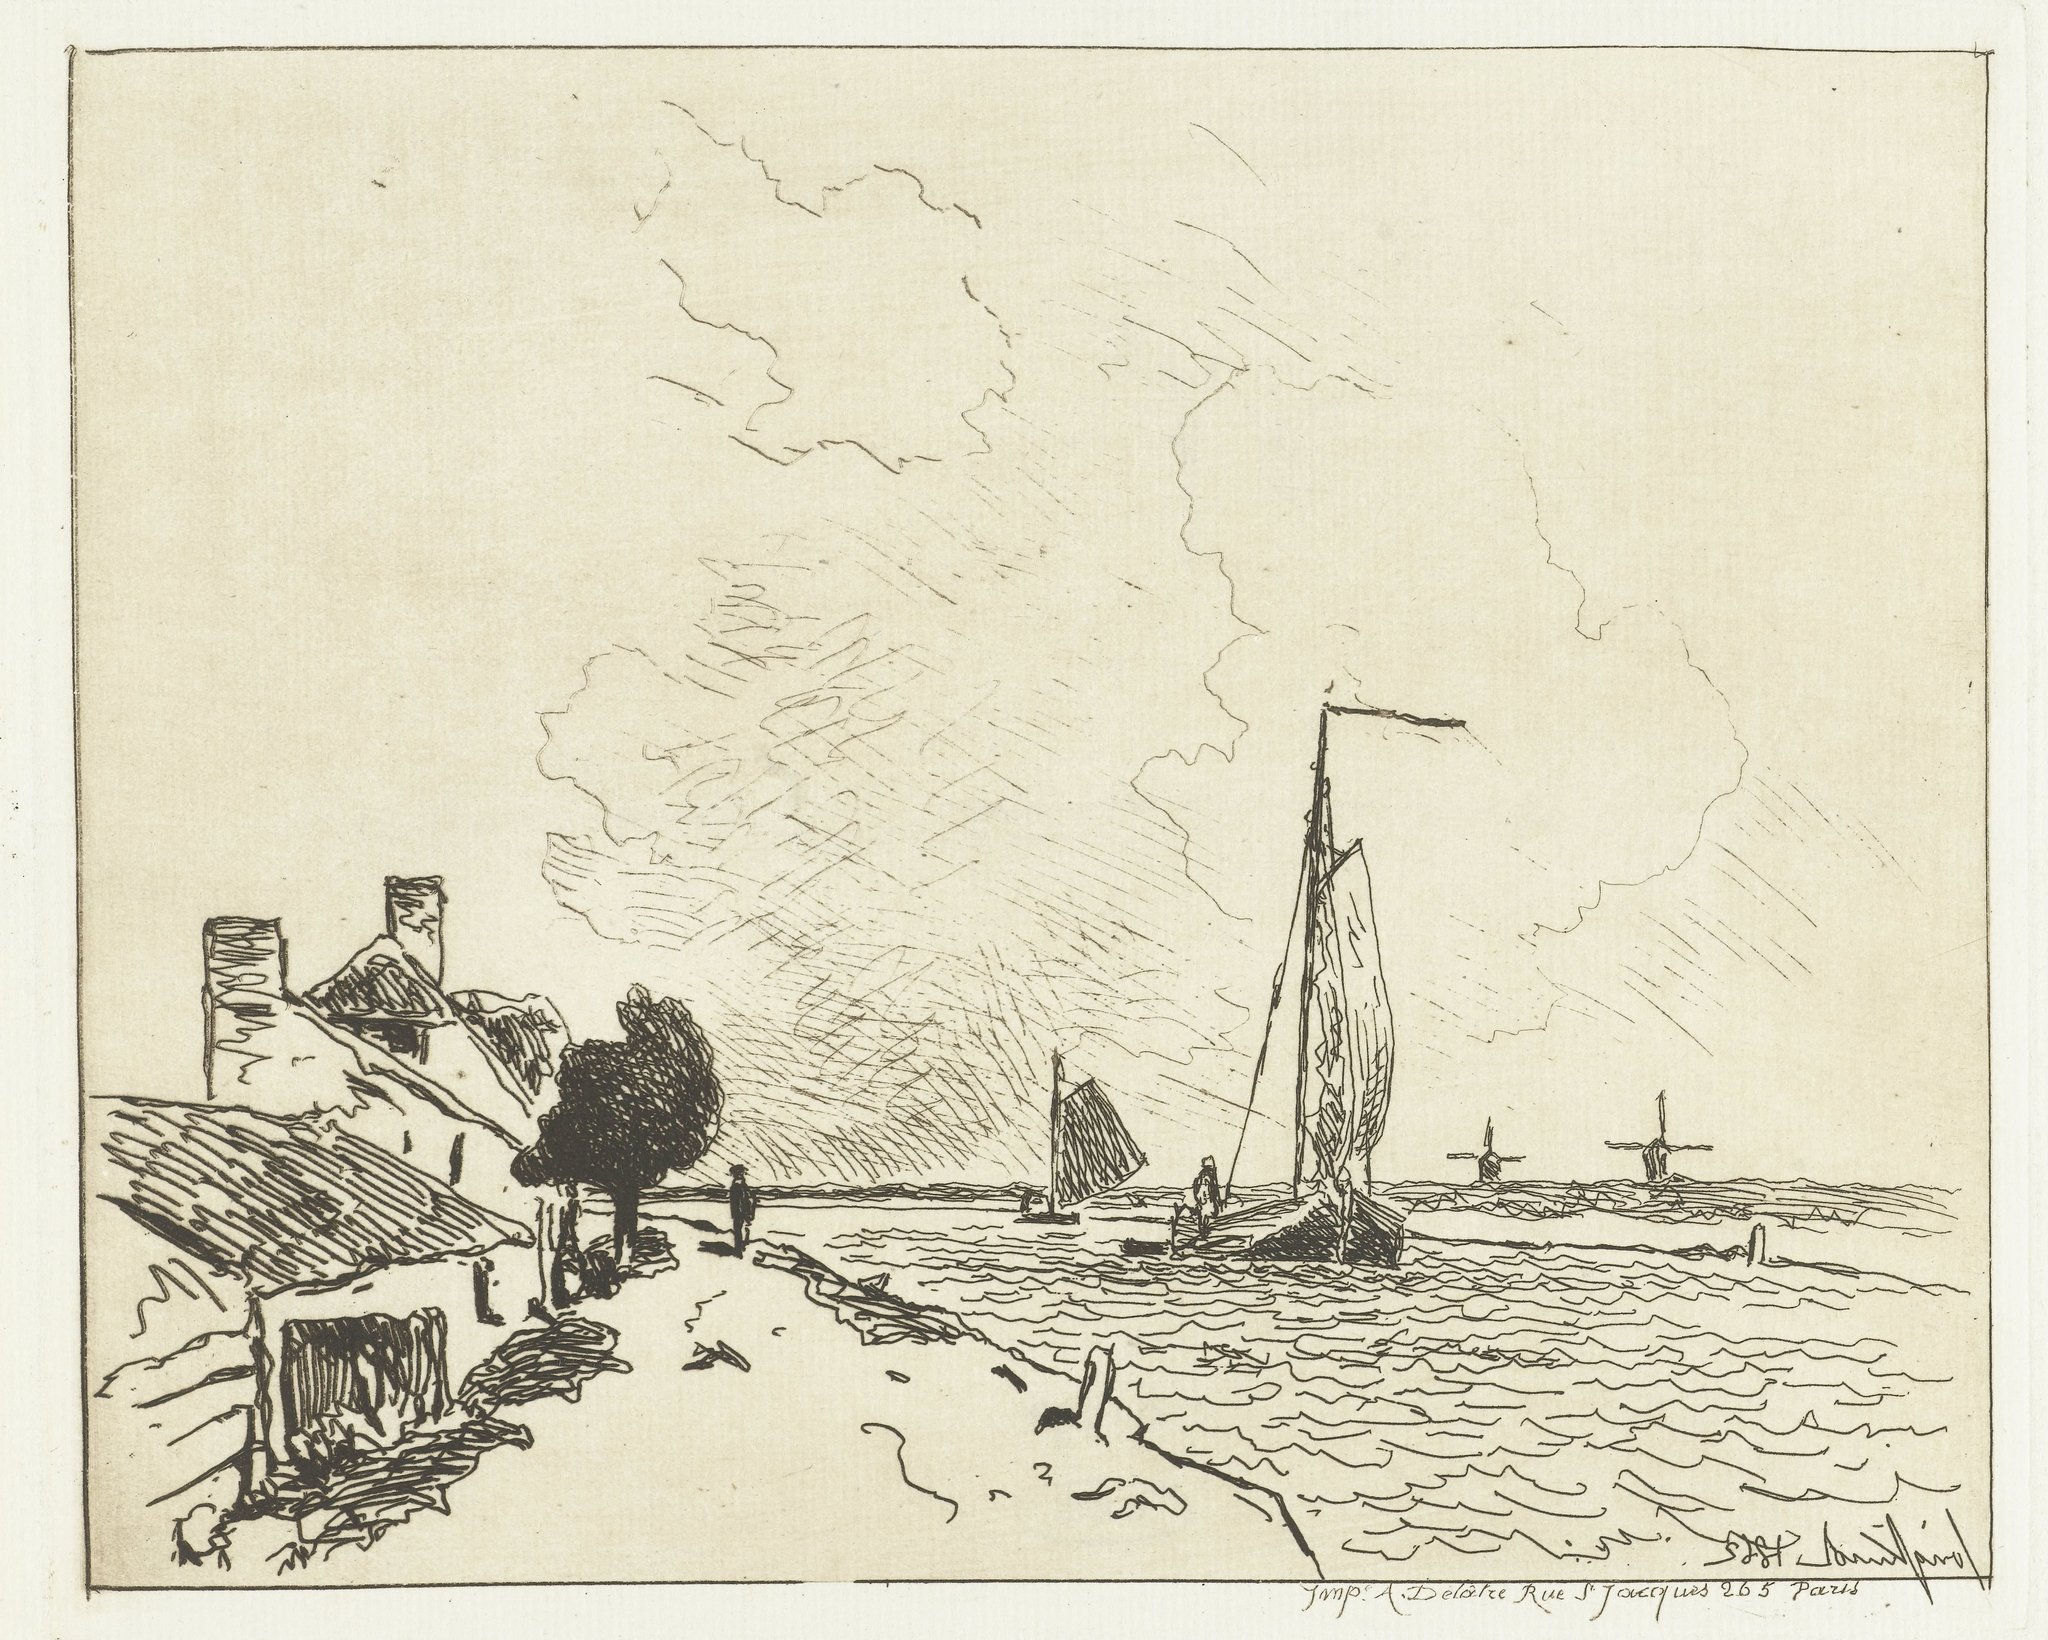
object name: print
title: Twee zeilschepen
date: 1862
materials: paper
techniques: etching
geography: paris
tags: landscapes in the temperate zone, ships (in general), windmill in landscape, holland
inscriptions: collector's mark: Lugt 2228a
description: Gezicht op een water met twee zeilschepen. Links een aantal huizen aan de waterkant. Rechts op de achtergrond twee molens. Deze prent is onderdeel van een serie van zes geëtste Hollandse gezichten (de eerste twee genummerd), het geheel voorafgegaan door een titelblad.